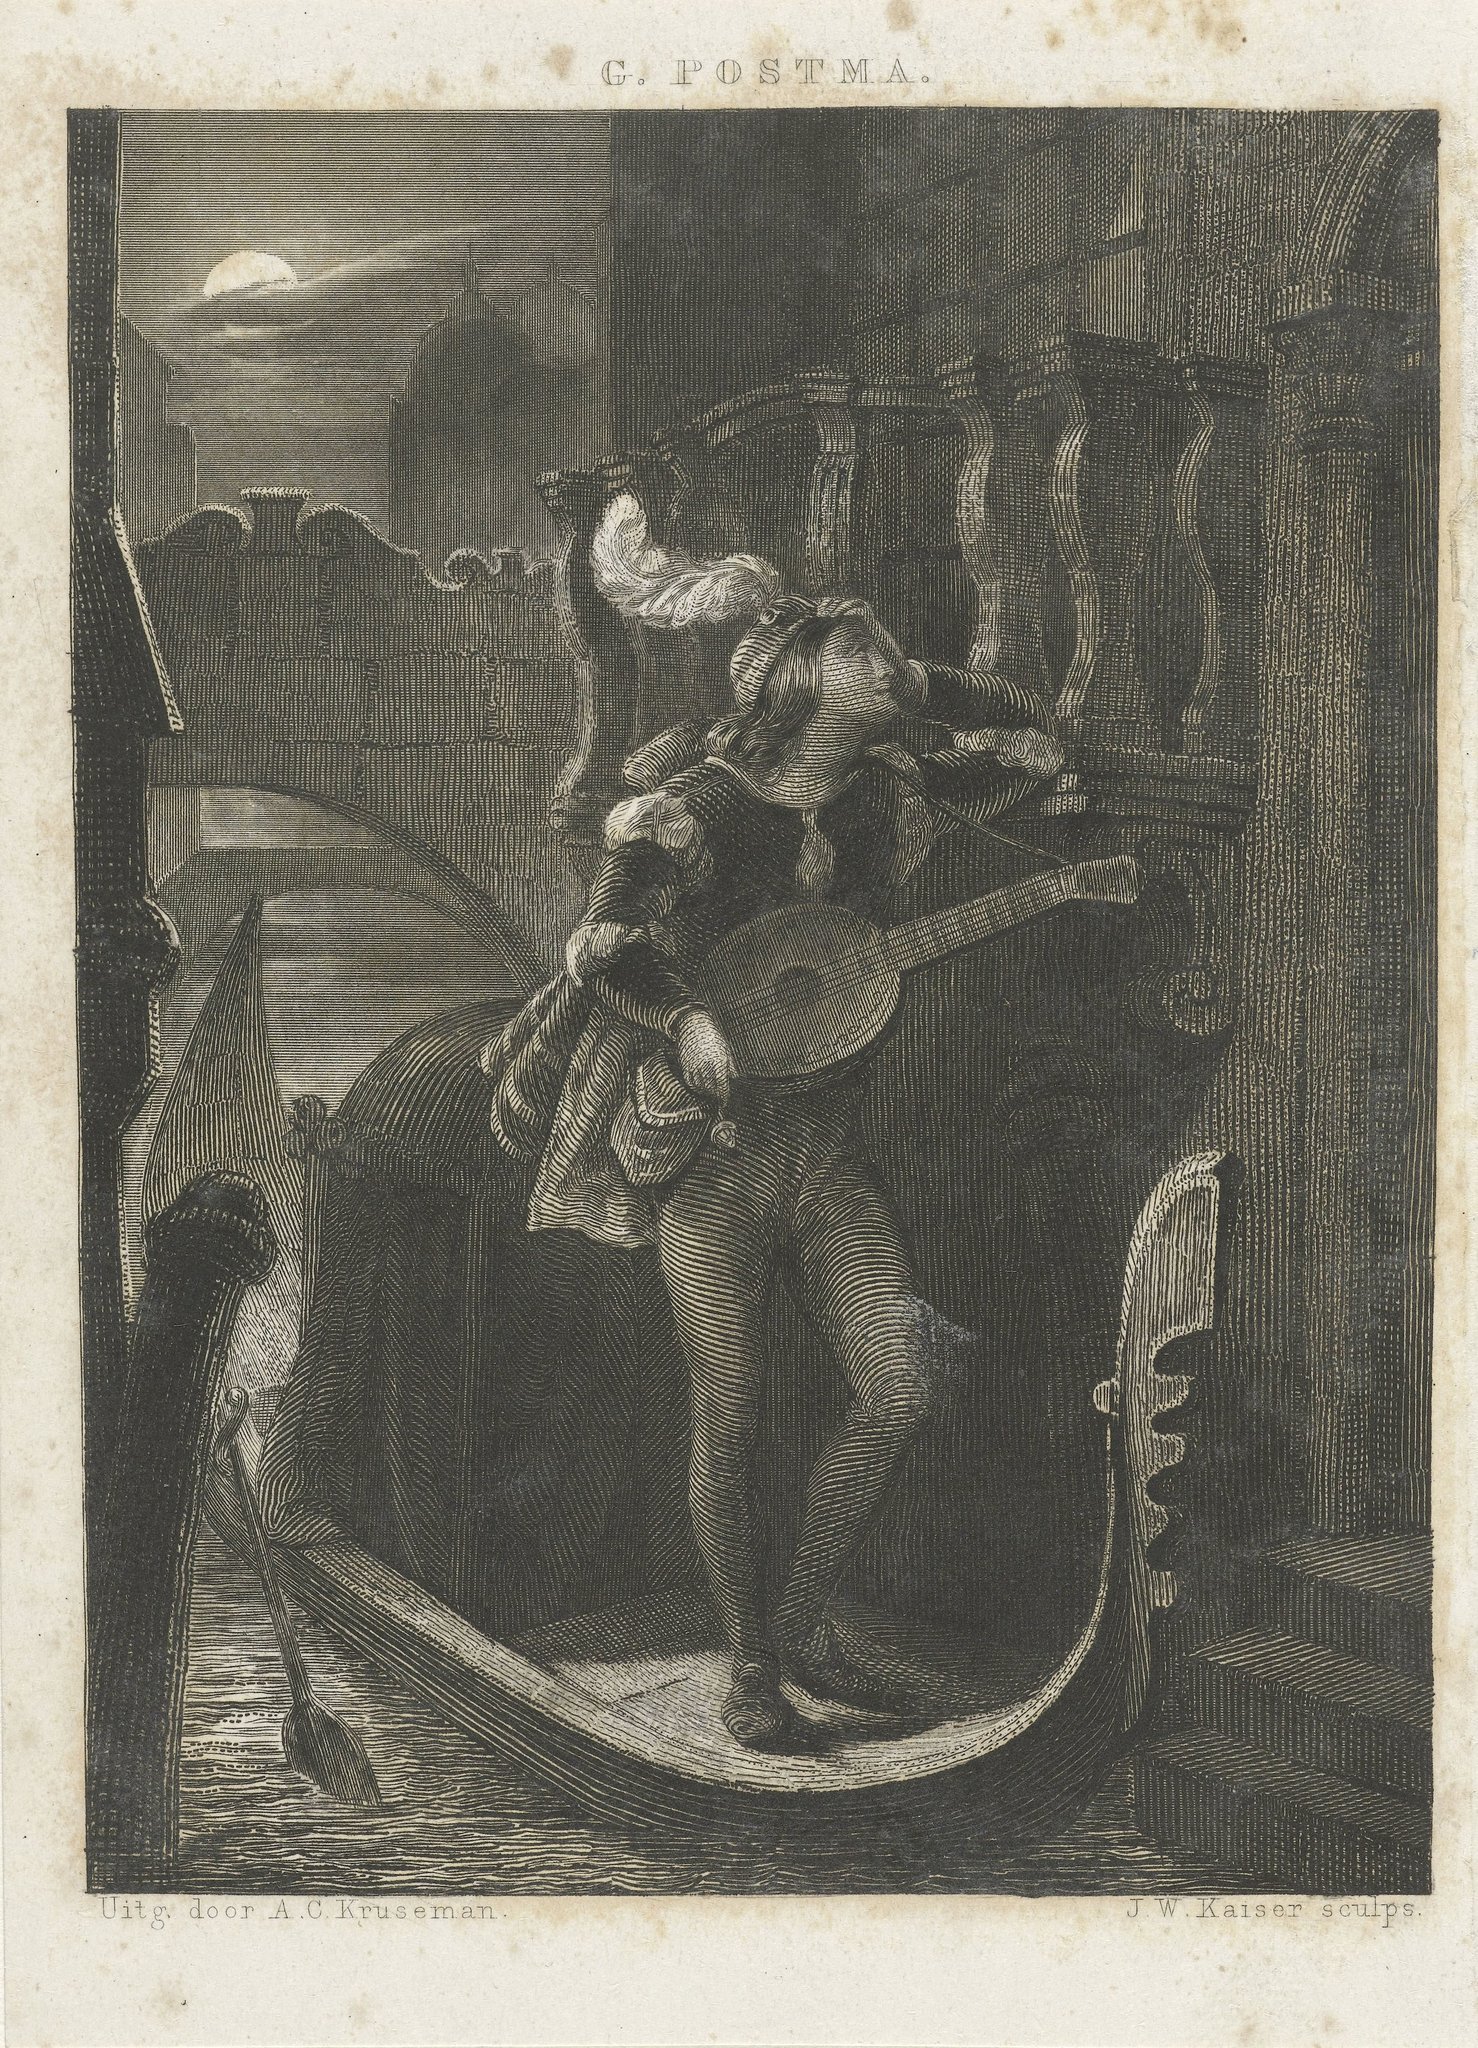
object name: print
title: Gondel bij maneschijn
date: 1840-1877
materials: paper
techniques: etching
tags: full moon, tuning the lute, gondola, venice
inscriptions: : ‘Uit Aurora 18?2’, collector's mark: Lugt 2228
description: Een jongeman staat bij maanlicht in een gondel, een luit in de handen, voor een deur van een woning in Venetië. Hij heeft een geldbuidel om. Op de achtergrond twee bruggen.